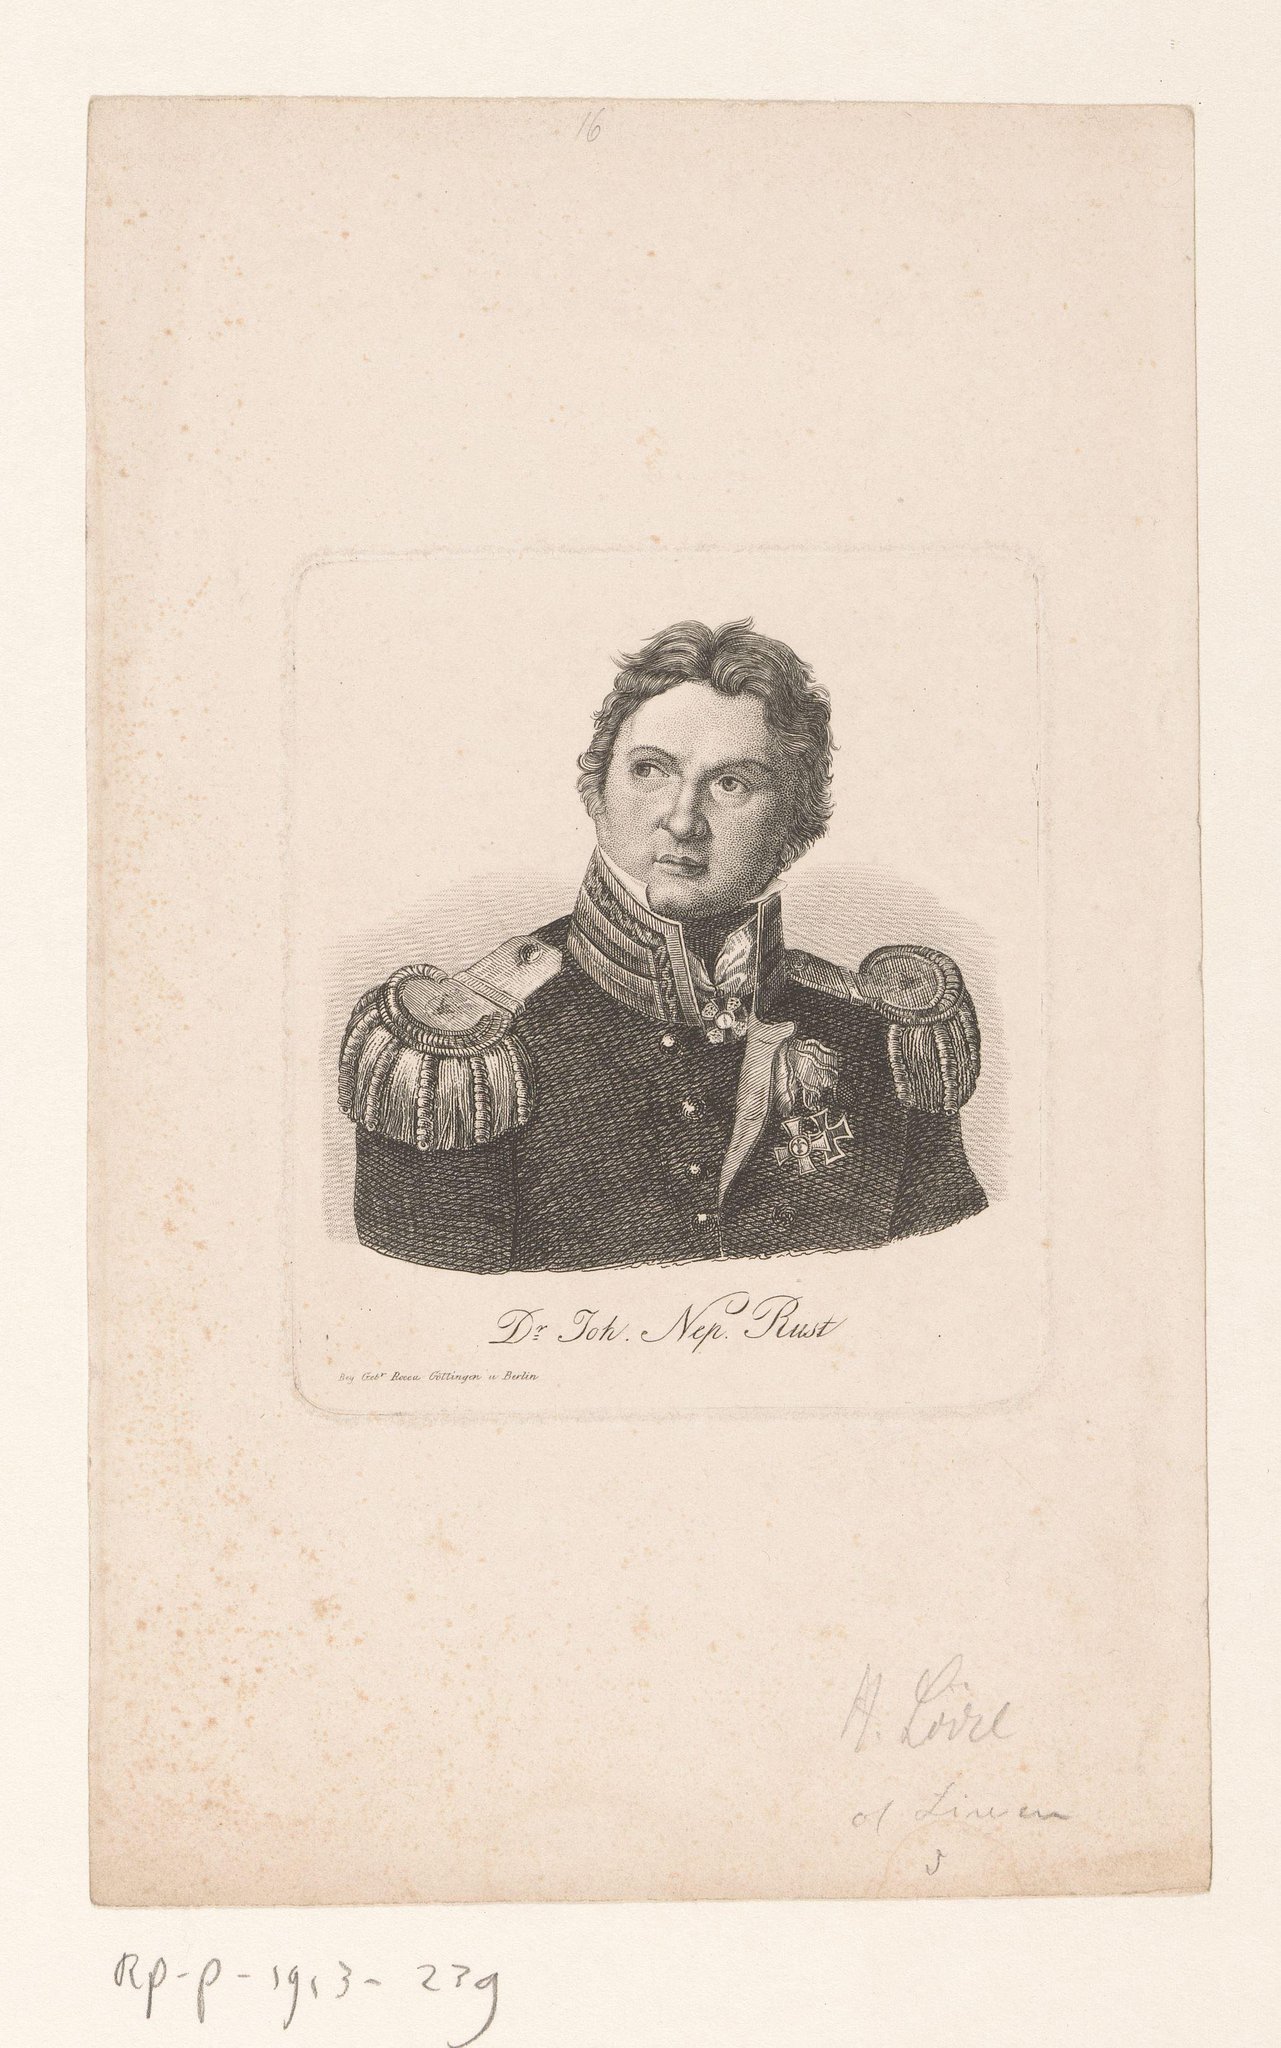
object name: print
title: Portret van Johann Nepomuk Rust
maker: heinrich lödel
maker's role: print maker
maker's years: 1798-1861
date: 1808-1861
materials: paper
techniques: engraving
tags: johann nepomuk rust, historical persons, physician, doctor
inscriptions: collector's mark: Lugt 2228